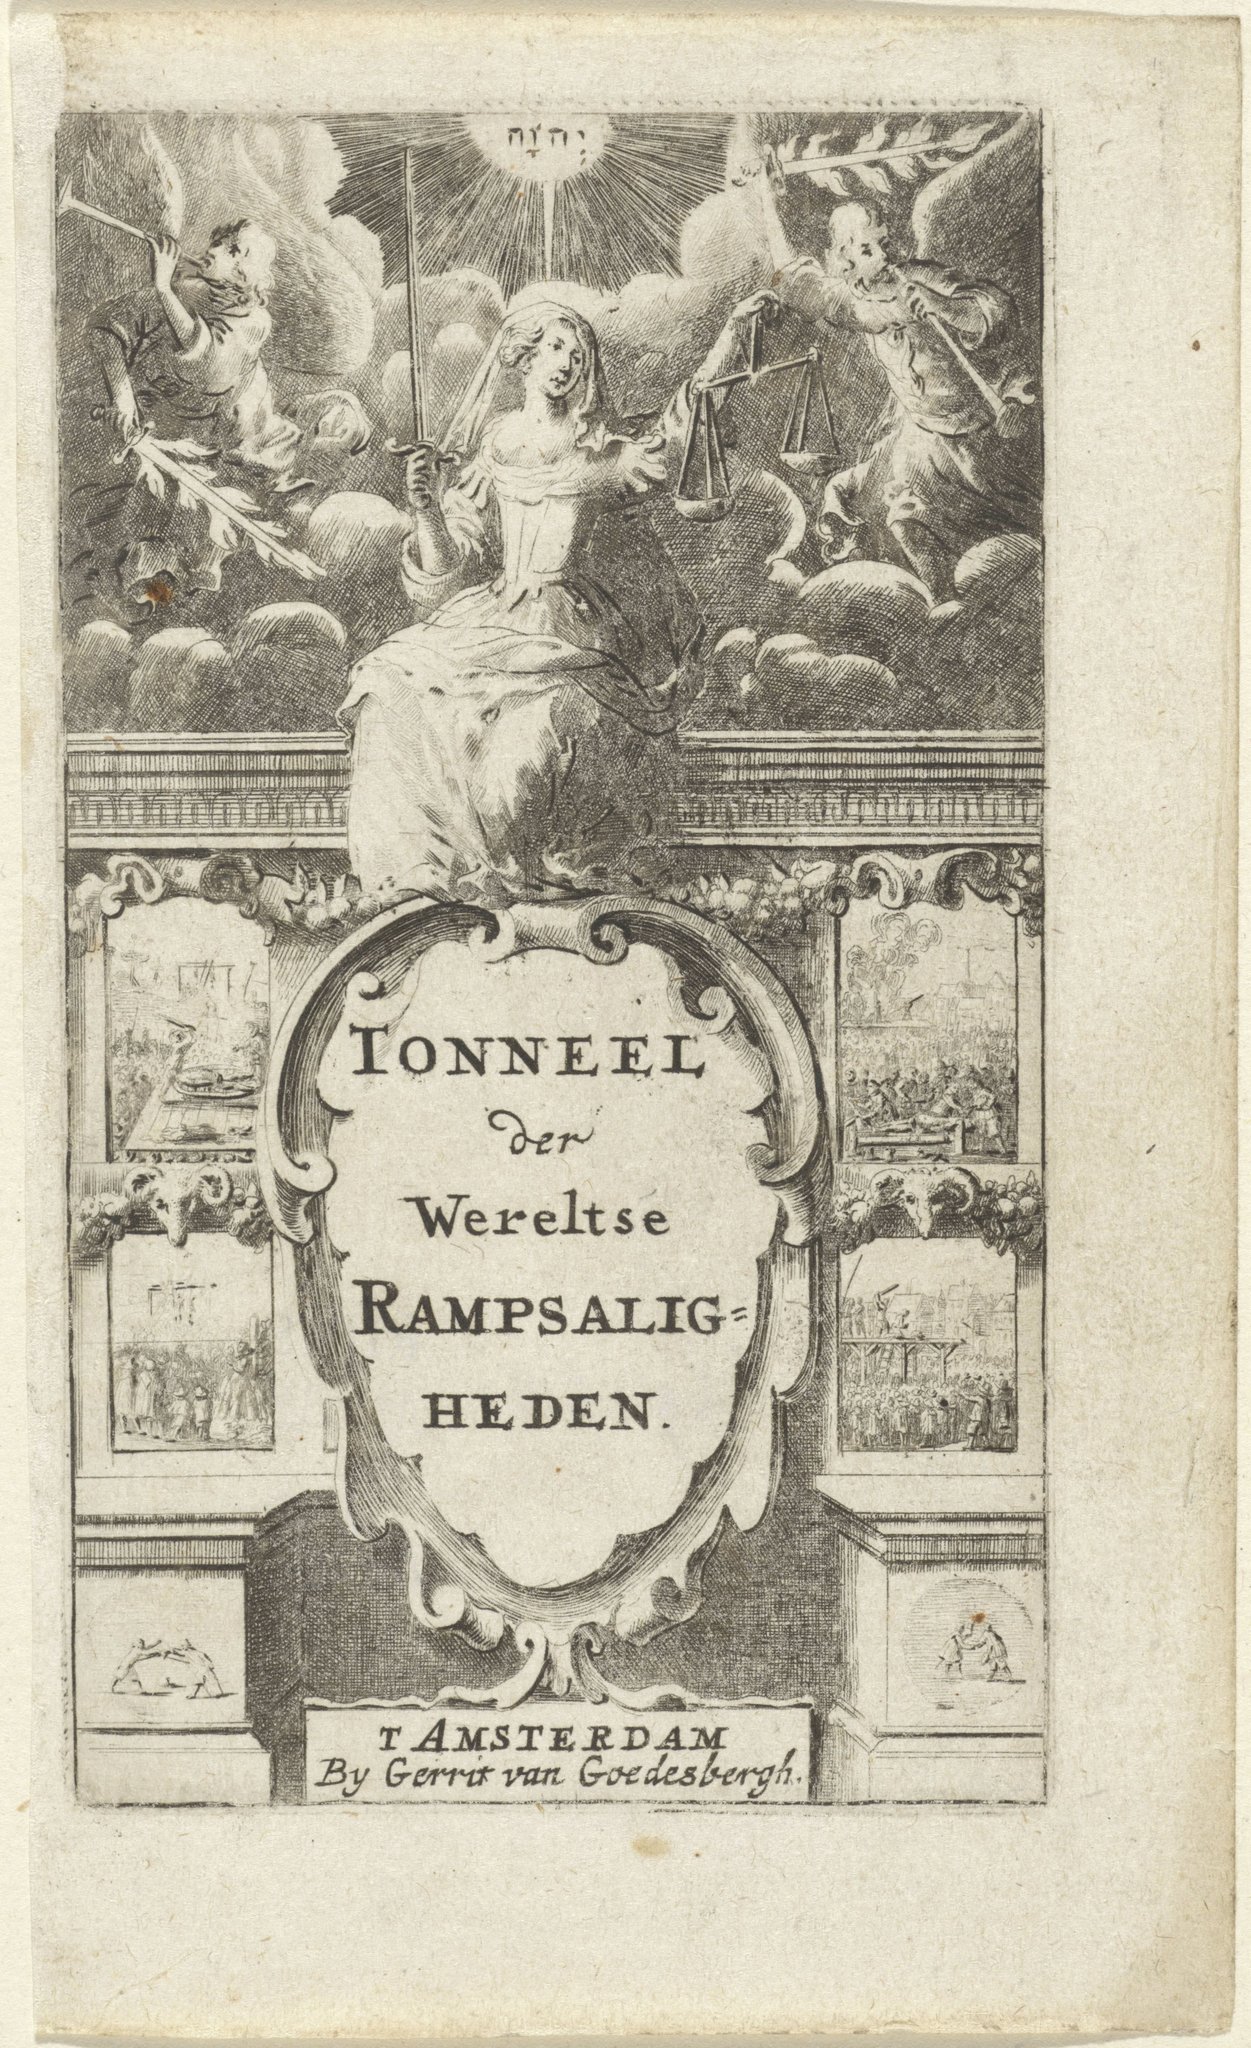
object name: print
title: Justitia troont boven voorstellingen van de doodstraf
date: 1667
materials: paper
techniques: etching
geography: netherlands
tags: title-page, death penalty, execution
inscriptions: collector's mark: Lugt 2760, collector's mark: Lugt 2166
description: Titelpagina voor: Reynolds, Johan. Tonneel der wereltse rampsaligheden, Amsterdam: Gerrit van Goedesbergh, 1667